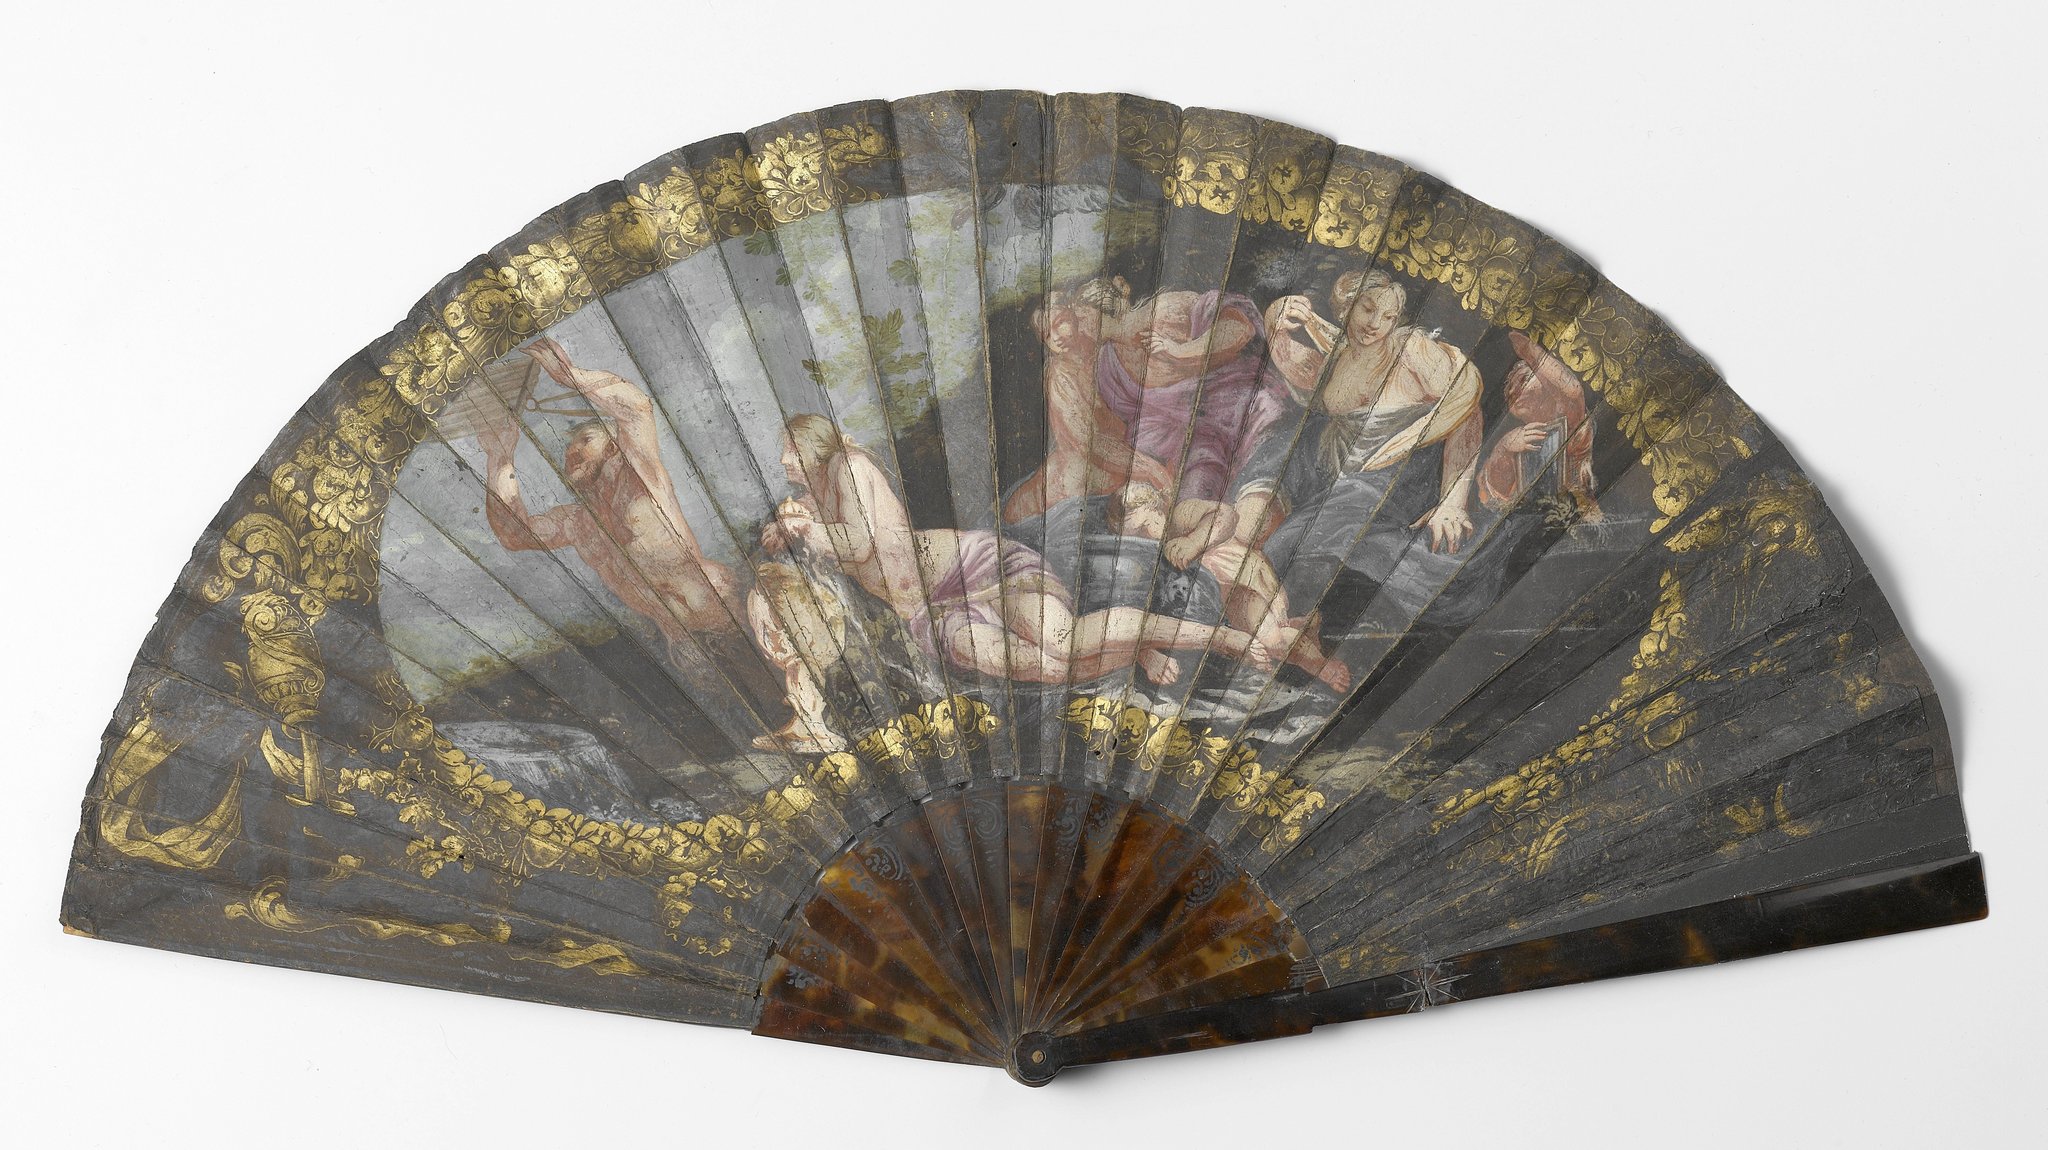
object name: vouwwaaier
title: Vouwwaaier met leren blad, waarop met gouache Pan en de Naiaden is geschilderd, op een schildpad montuur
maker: Anonymous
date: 1650-1699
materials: gouache, leather, paint, shell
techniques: cutting, fastening, painted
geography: france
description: Model: doordat de twee meest rechtse benen in het verleden op elkaar zijn geplakt, heeft de waaier tegenwoordig een asymmetrische versiering en is nu nog alleen de linker reserve zichtbaar met hierin een omgekeerde vaas waar water uit stroomt. Een vaas of kruik gold als attribuut van de waternimfen of Naiaden, die bij het water leefden. Versiering: de central afgebeelde nimf steunt op een vaas en kijkt toe hoe Pan, haar meester, met een panfluit in de hand plotseling uit het water oprijst. Aan haar voeten buigt een putto zich over een vaas. De nimf rechts is bezig met haar toilet en kijkt hiertoe in een spiegel, die door een putto voor haar wordt opgehouden. De twee nimfen op de achtergrond lijken in een gesprek verwikkeld. In de griekse mythologie waren nimfen oorspronkelijk huwbare meisjes; later werden zij godinnen, maar steeds bleven zij het symbool van de jonge en mooie vrouw. De mythologische voorstelling is omgeven door een rand van goudkleurige vruchten eb bladeren in de trant van de Franse graveur Jean Le Pautre (1618-1682). Met name de enigszins plompe vorm van de vruchten en de manier waarop deze tussen het blad- en loofwerk zijn geranschikt, vertoont grote gelijkenis met de voorbeelden opde prenten uit de serie 'Frises, Feulïllages ou Tritons Marins a la Romaine', die tussen 1657 en 1663 in Parijs verschenen. Op het montuur en op de achterkant van het blad zijn kleine acanthusachtige ornamenten in zilver geschilderd. Mogelijk was deze beschildering bedoeld als imitatie van de, met zilverdraad ingelegde, schildpadmonturen die aan het einde van de 17de eeuw in de mode kwamen.